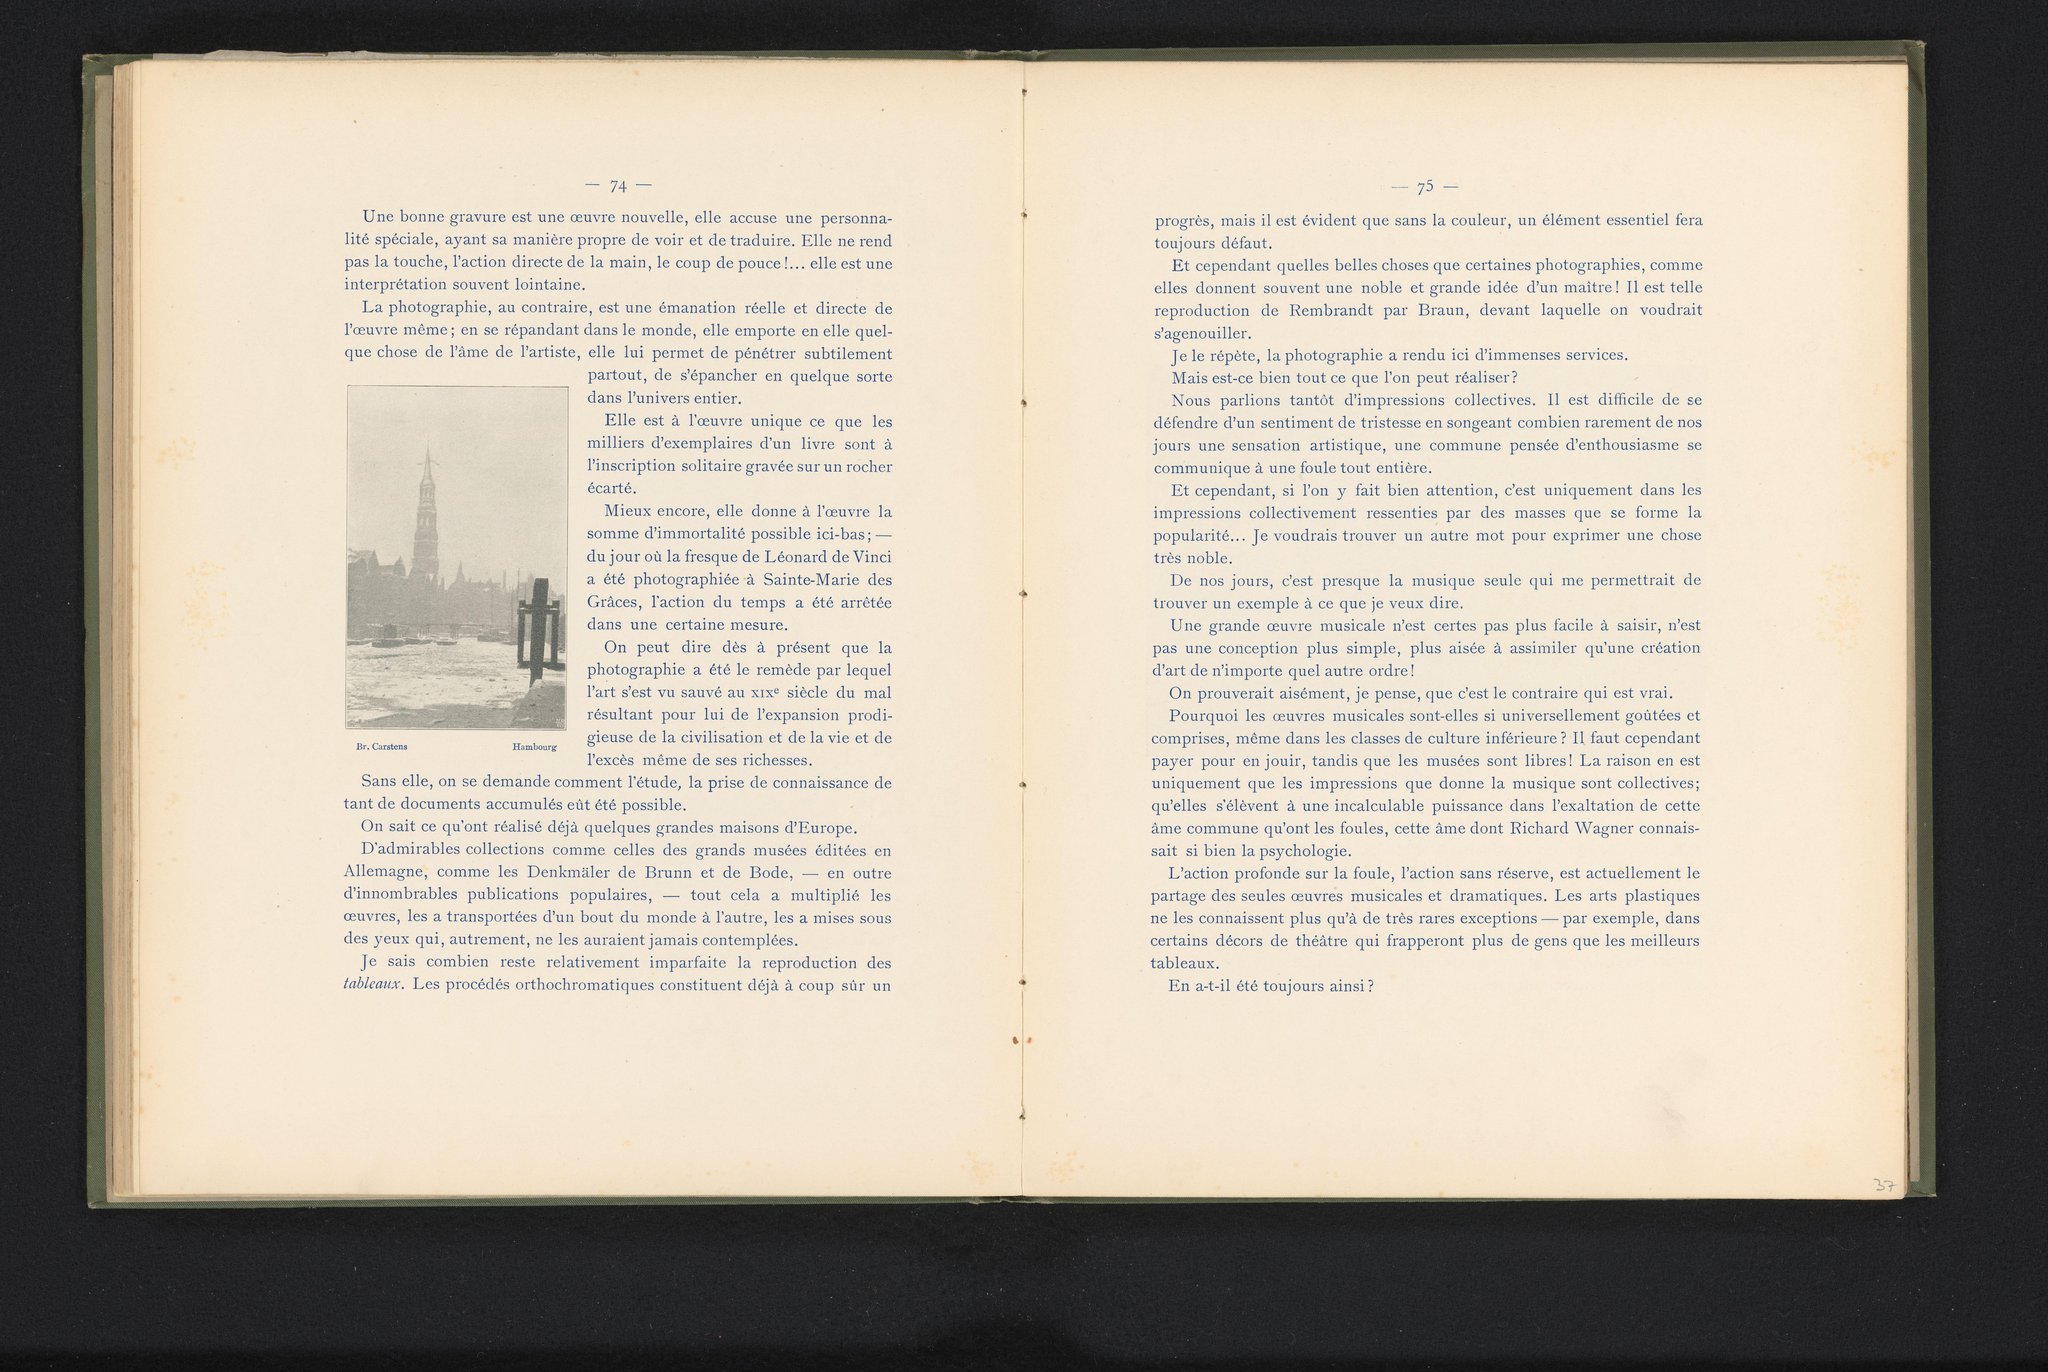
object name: photomechanical print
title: Gezicht op Hamburg in de sneeuw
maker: br. carstens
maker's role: dokter, fotograaf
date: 1893-1898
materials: paper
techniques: photograph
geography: hamburg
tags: city-view in general; 'veduta', snow